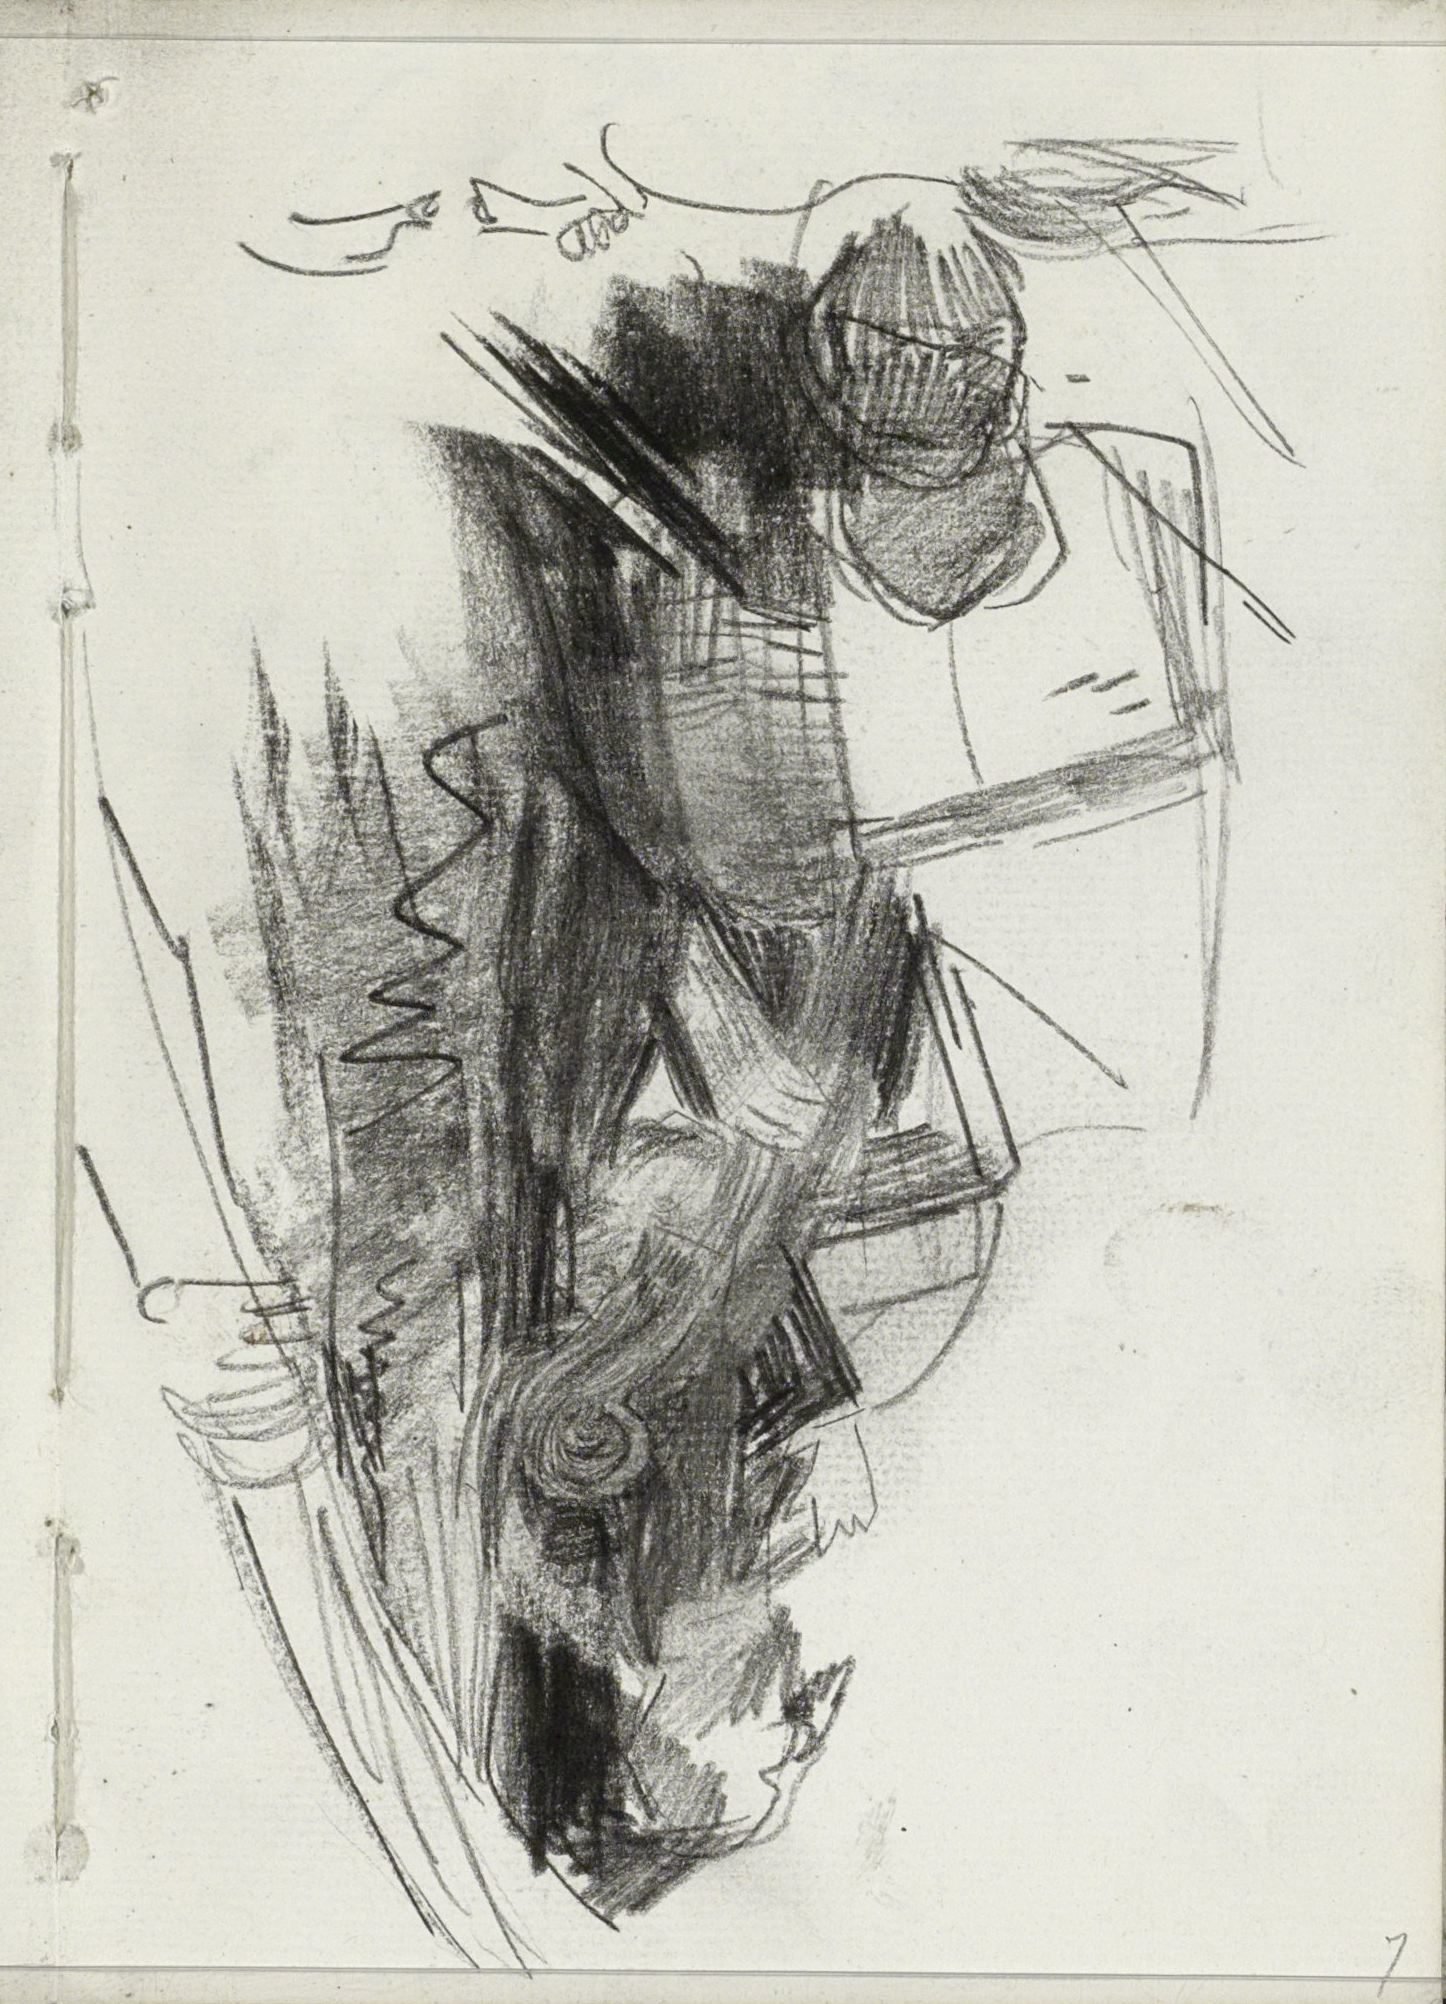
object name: sketchbook leaf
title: Cellist met toehoorders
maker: isaac israels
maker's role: draughtsman, painter, print maker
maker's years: 1865-1934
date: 1886-1903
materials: chalk, paper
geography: amsterdam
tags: viola, violoncello; double bass (+ artist at work), the audience ~ art performance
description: Mogelijk in Carré. Pagina 7 uit schetsboek XXXVII met 52 pagina's.